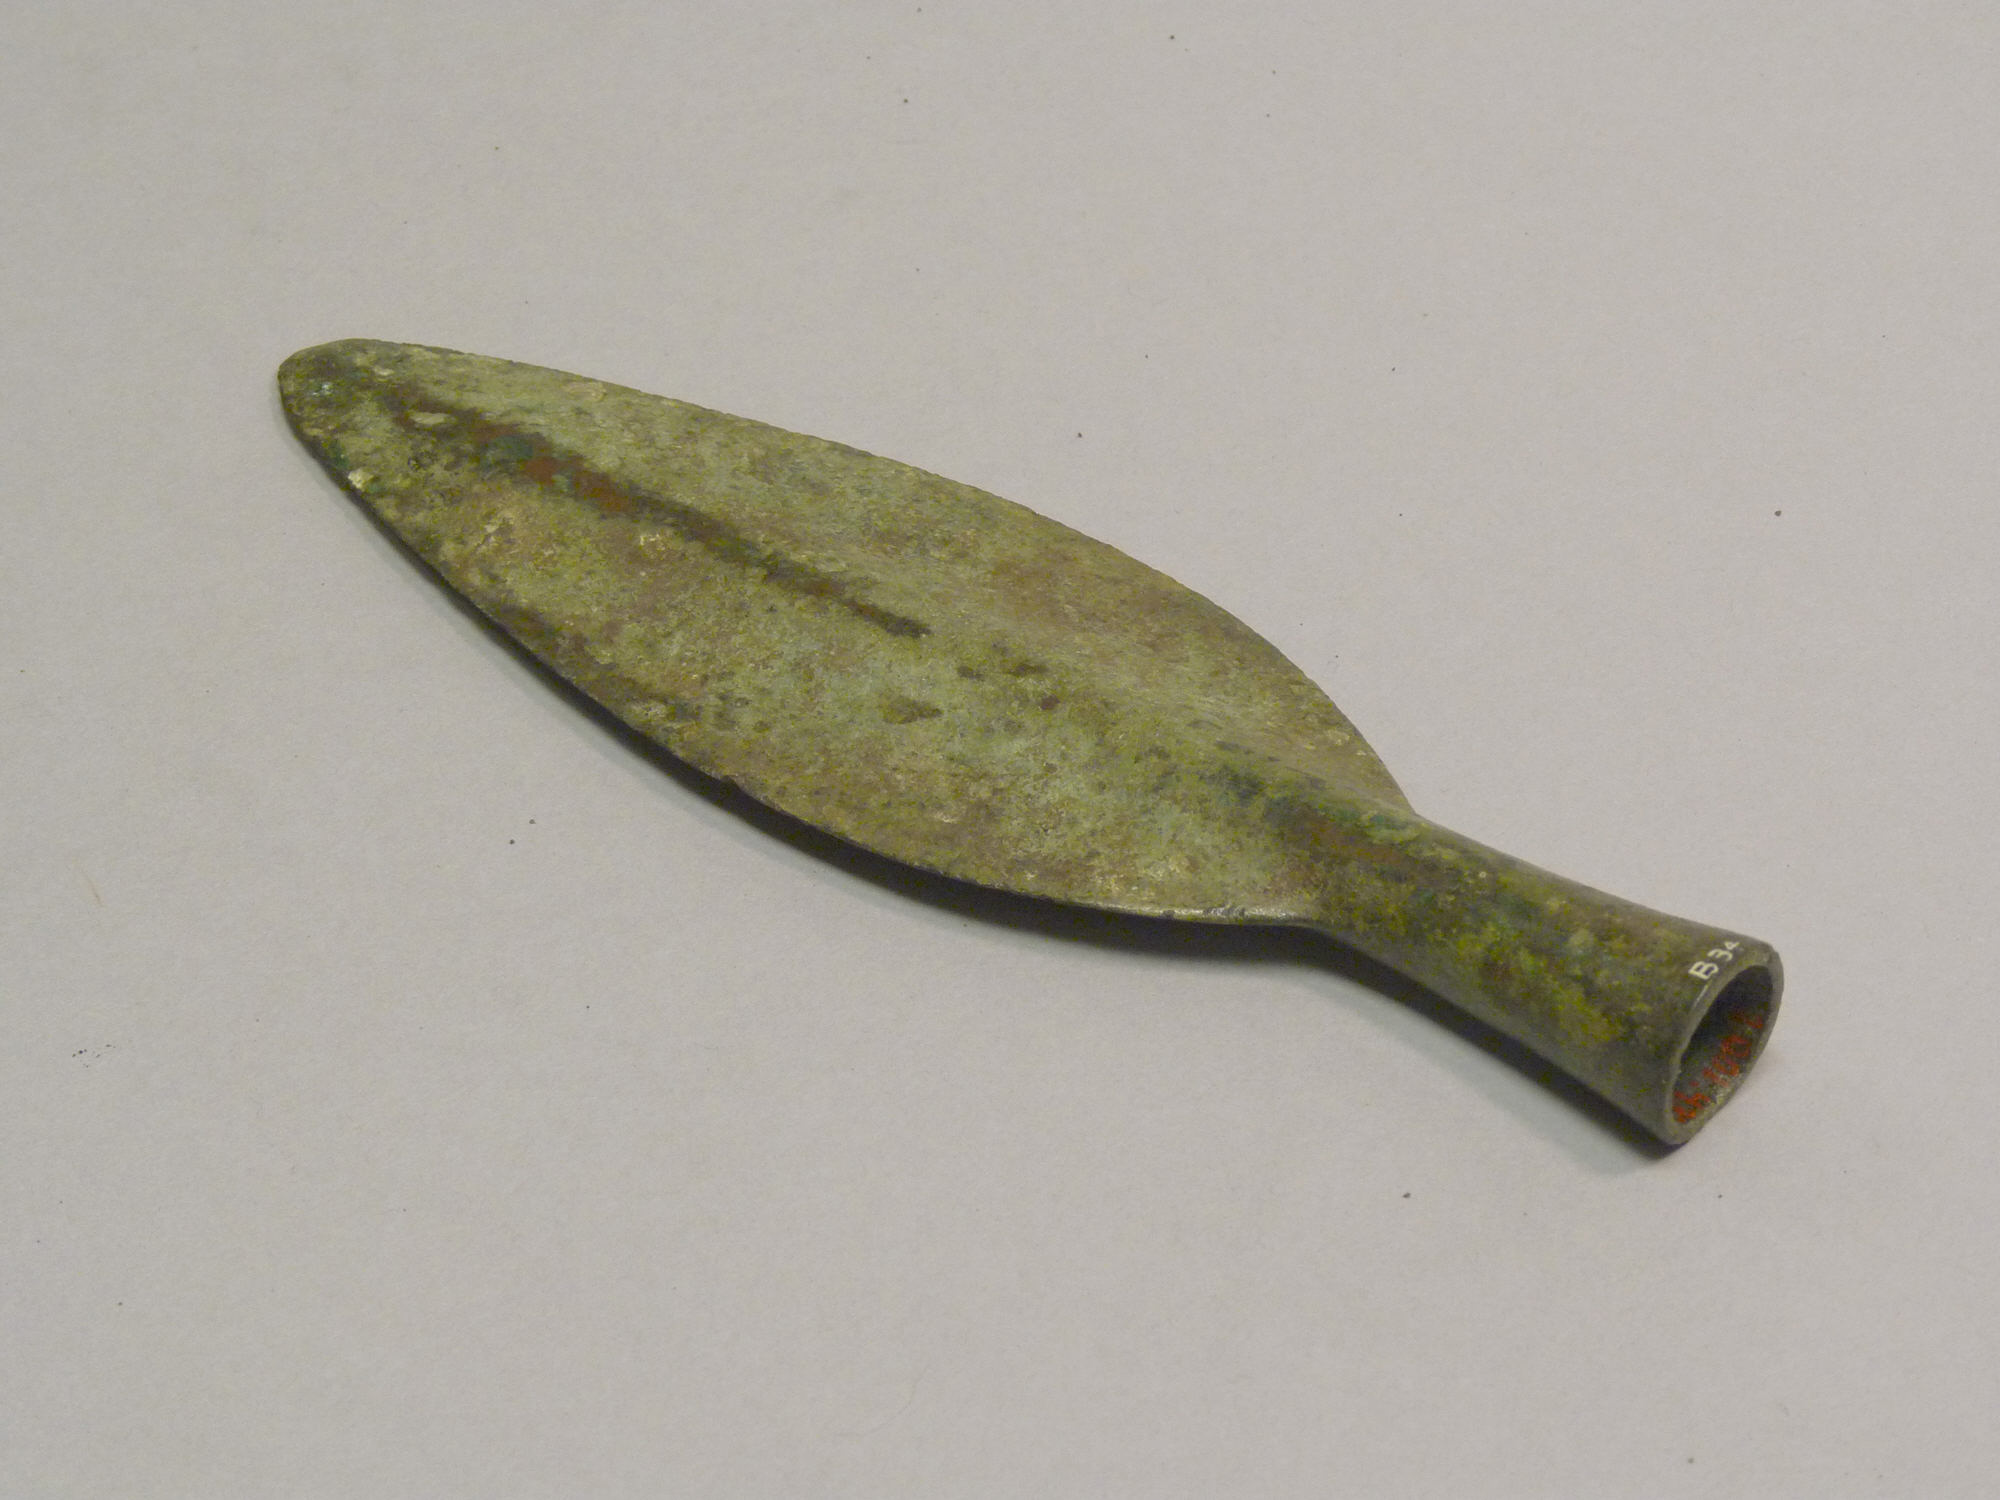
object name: knife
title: Blade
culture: indonesian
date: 500 BCE-300 CE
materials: bronze